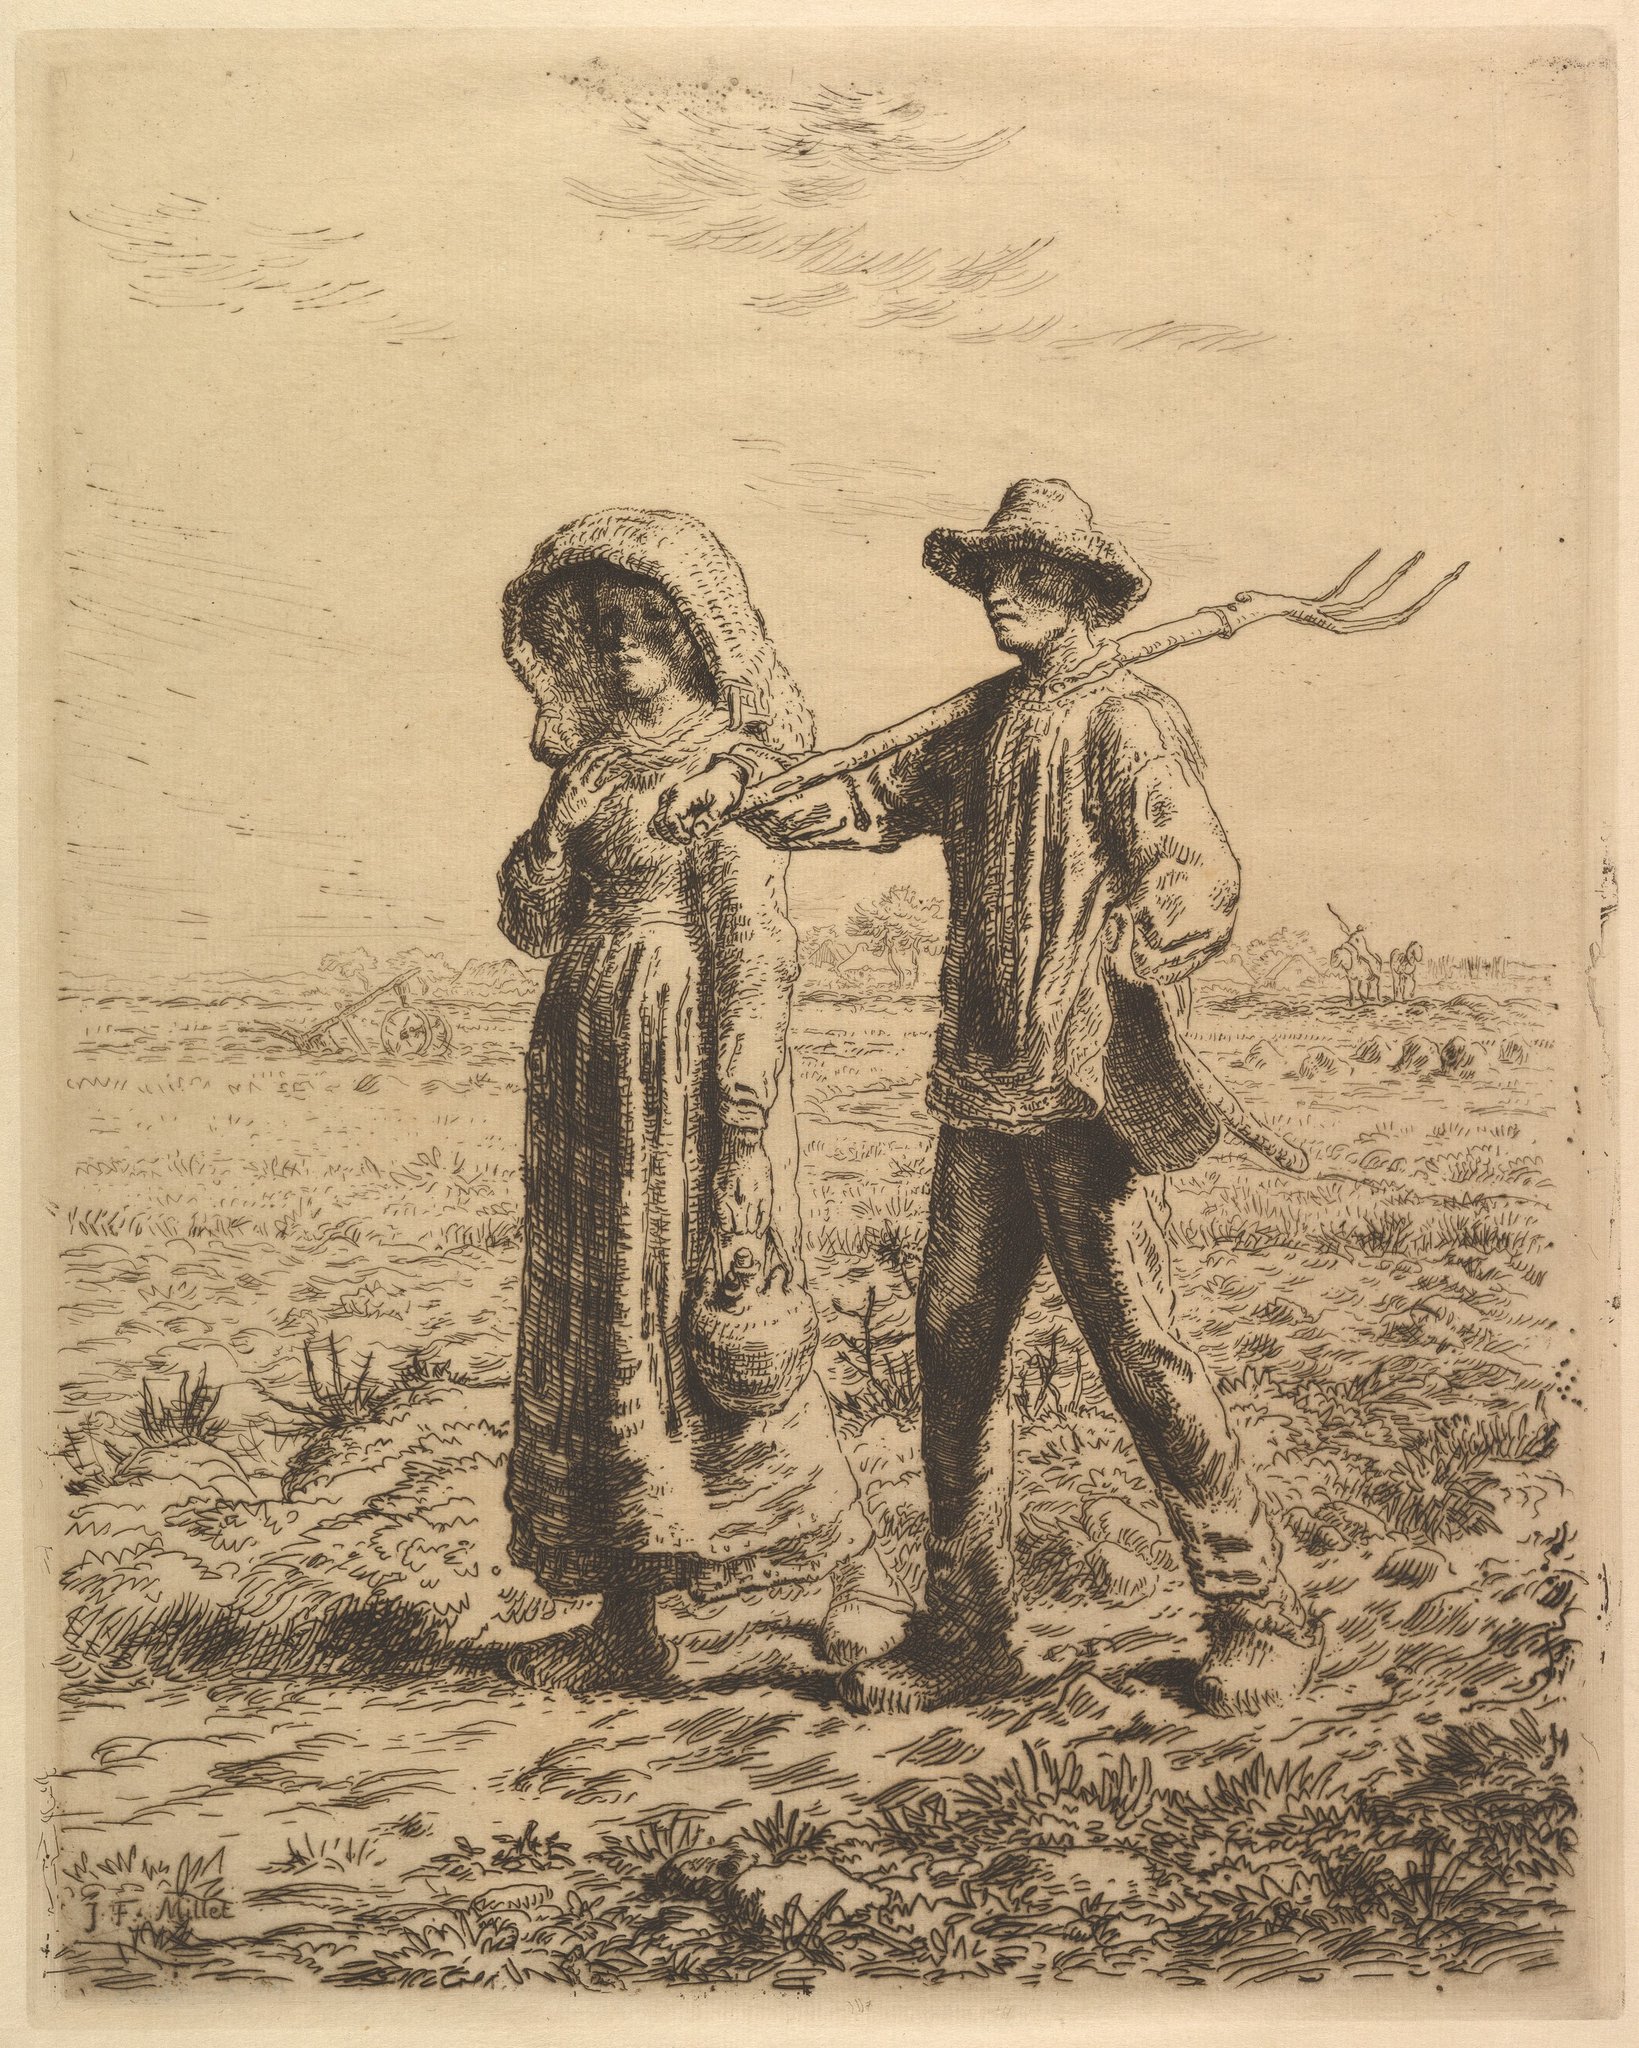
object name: print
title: Peasants Going to Work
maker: jean-françois millet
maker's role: artist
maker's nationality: french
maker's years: 1814-1875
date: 1863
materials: ink, paper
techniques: etching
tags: men,women